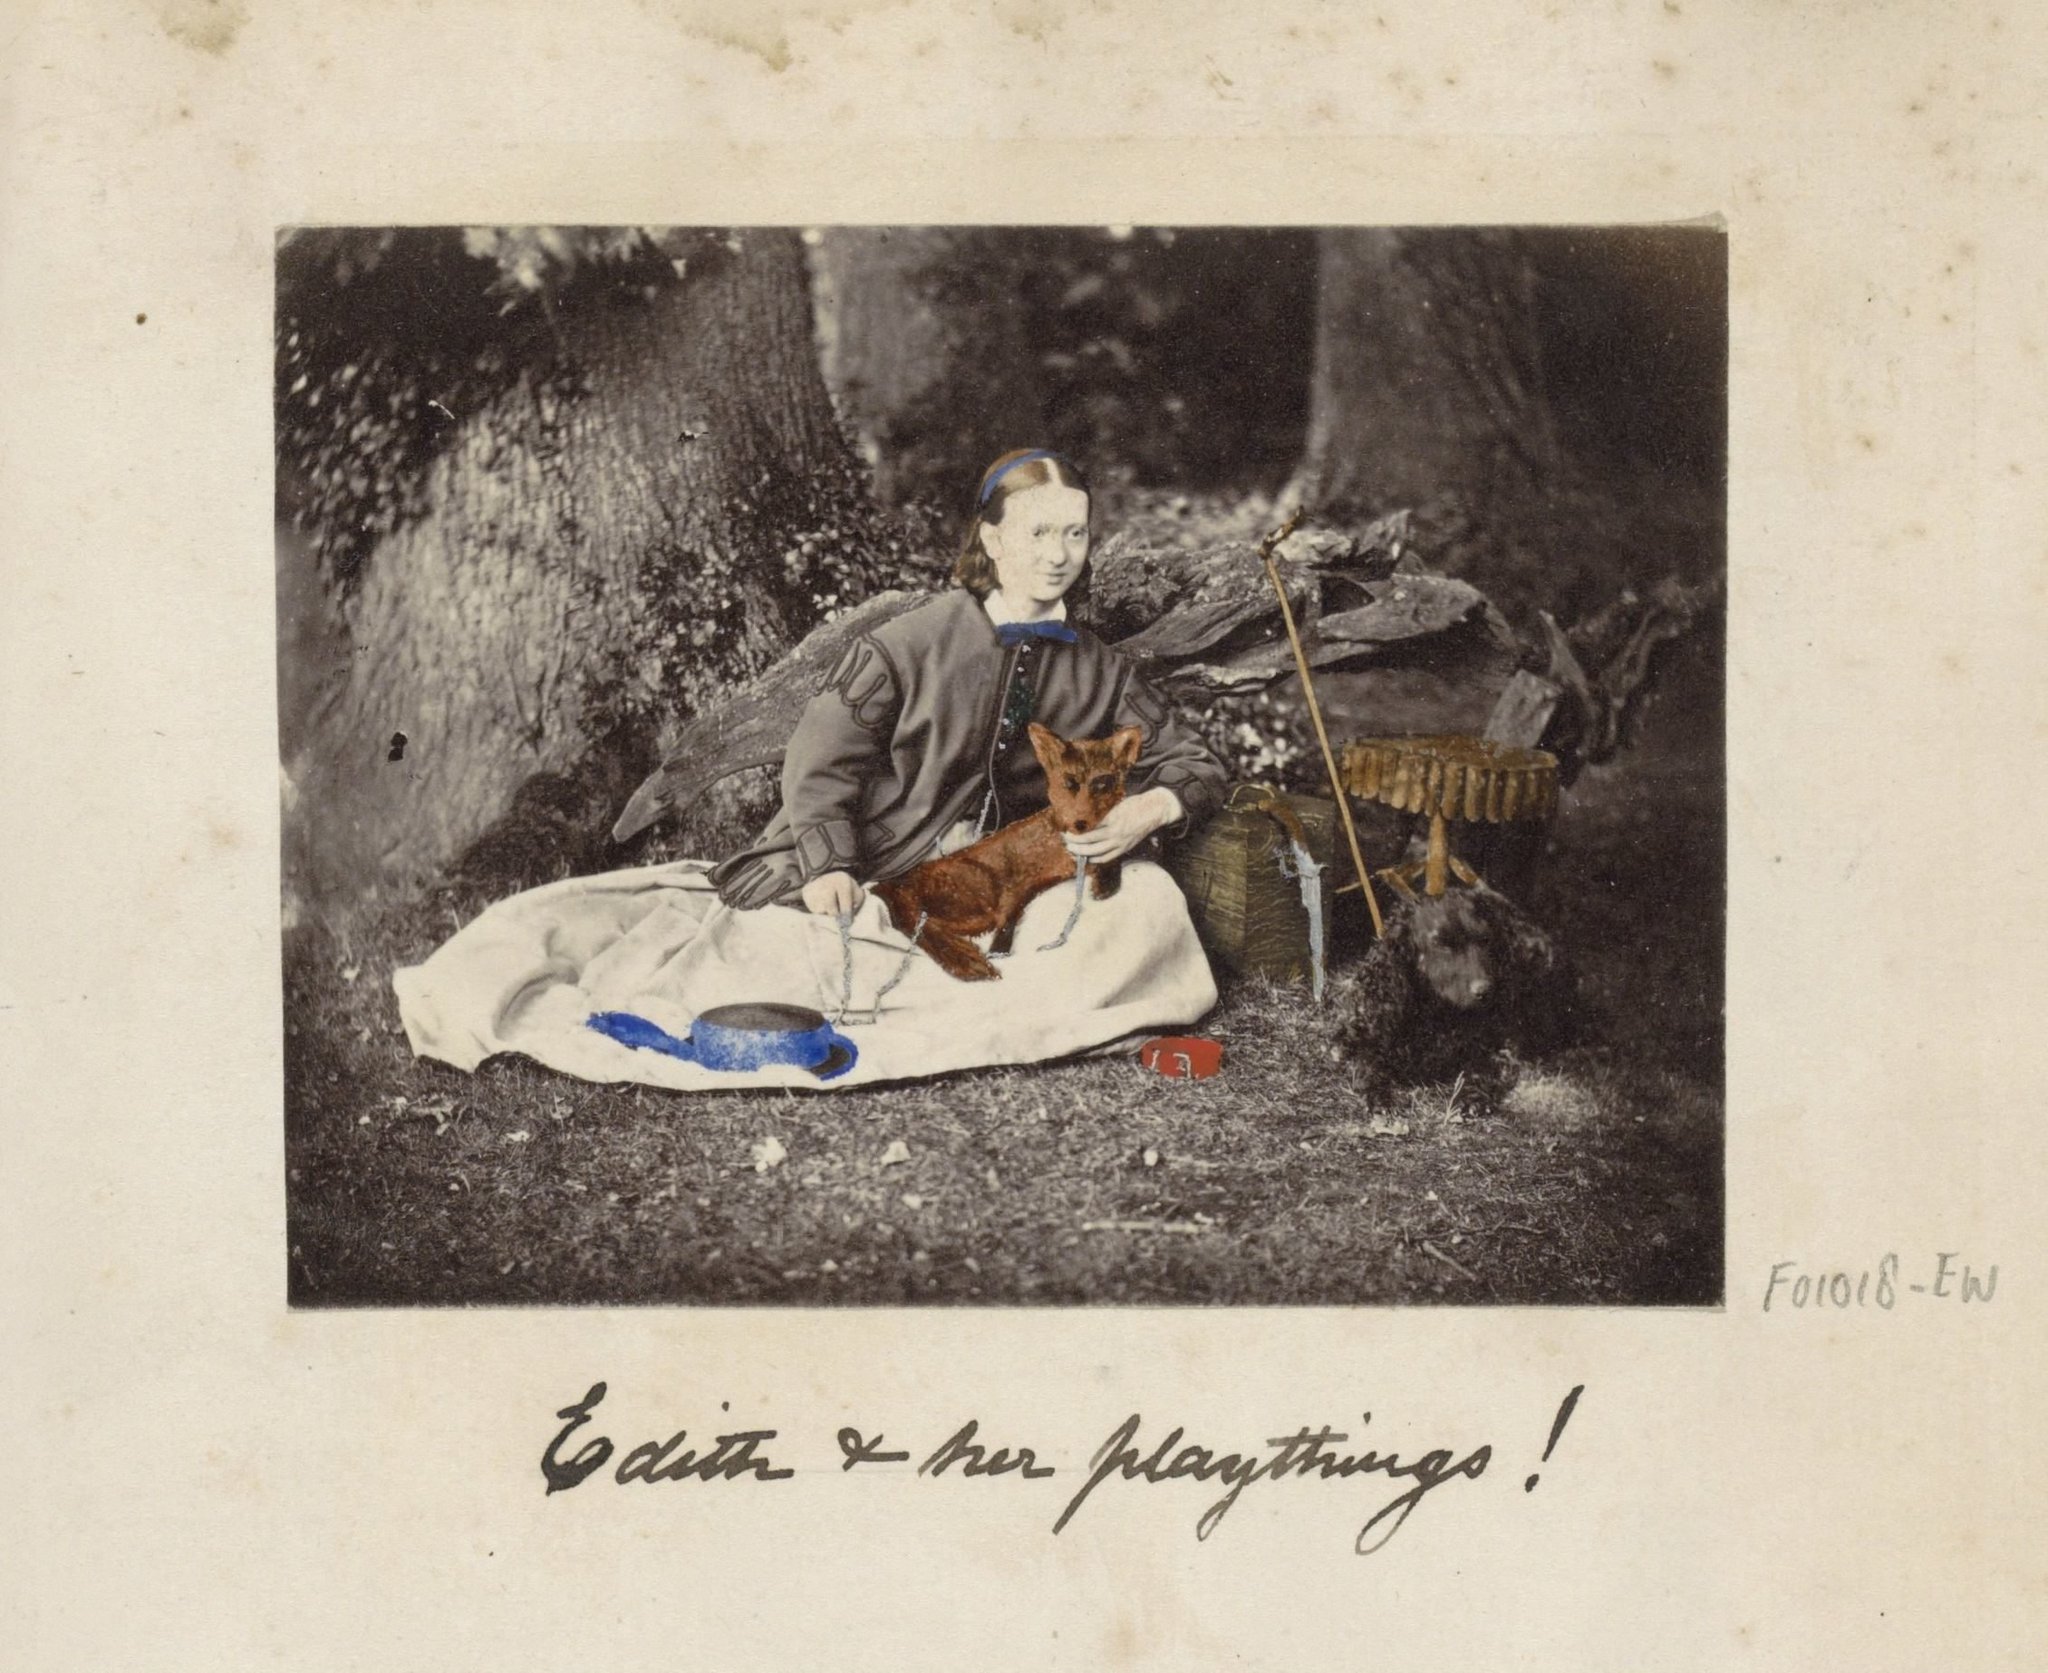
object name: photograph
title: Edith and her playthings!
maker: Anonymous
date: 1860-1870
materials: paper, photographic support, watercolor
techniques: albumen print, hand coloring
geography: great britain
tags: trees, adult woman, clothing for the upper part of the body, skirt, dog, great britain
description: Onderdeel van Engels familiealbum met foto's van personen, reizen, cricket en kunstwerken.